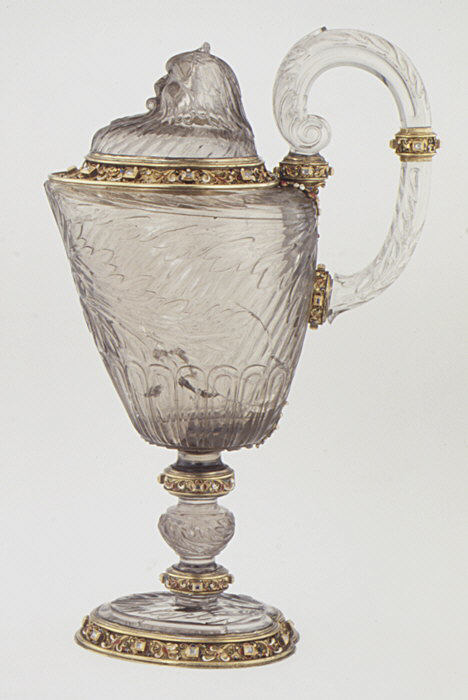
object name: ewer with cover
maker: reinhold vasters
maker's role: artist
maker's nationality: german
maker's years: 1827-1909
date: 1851-1900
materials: diamond, enamel, quartz, silver gilt